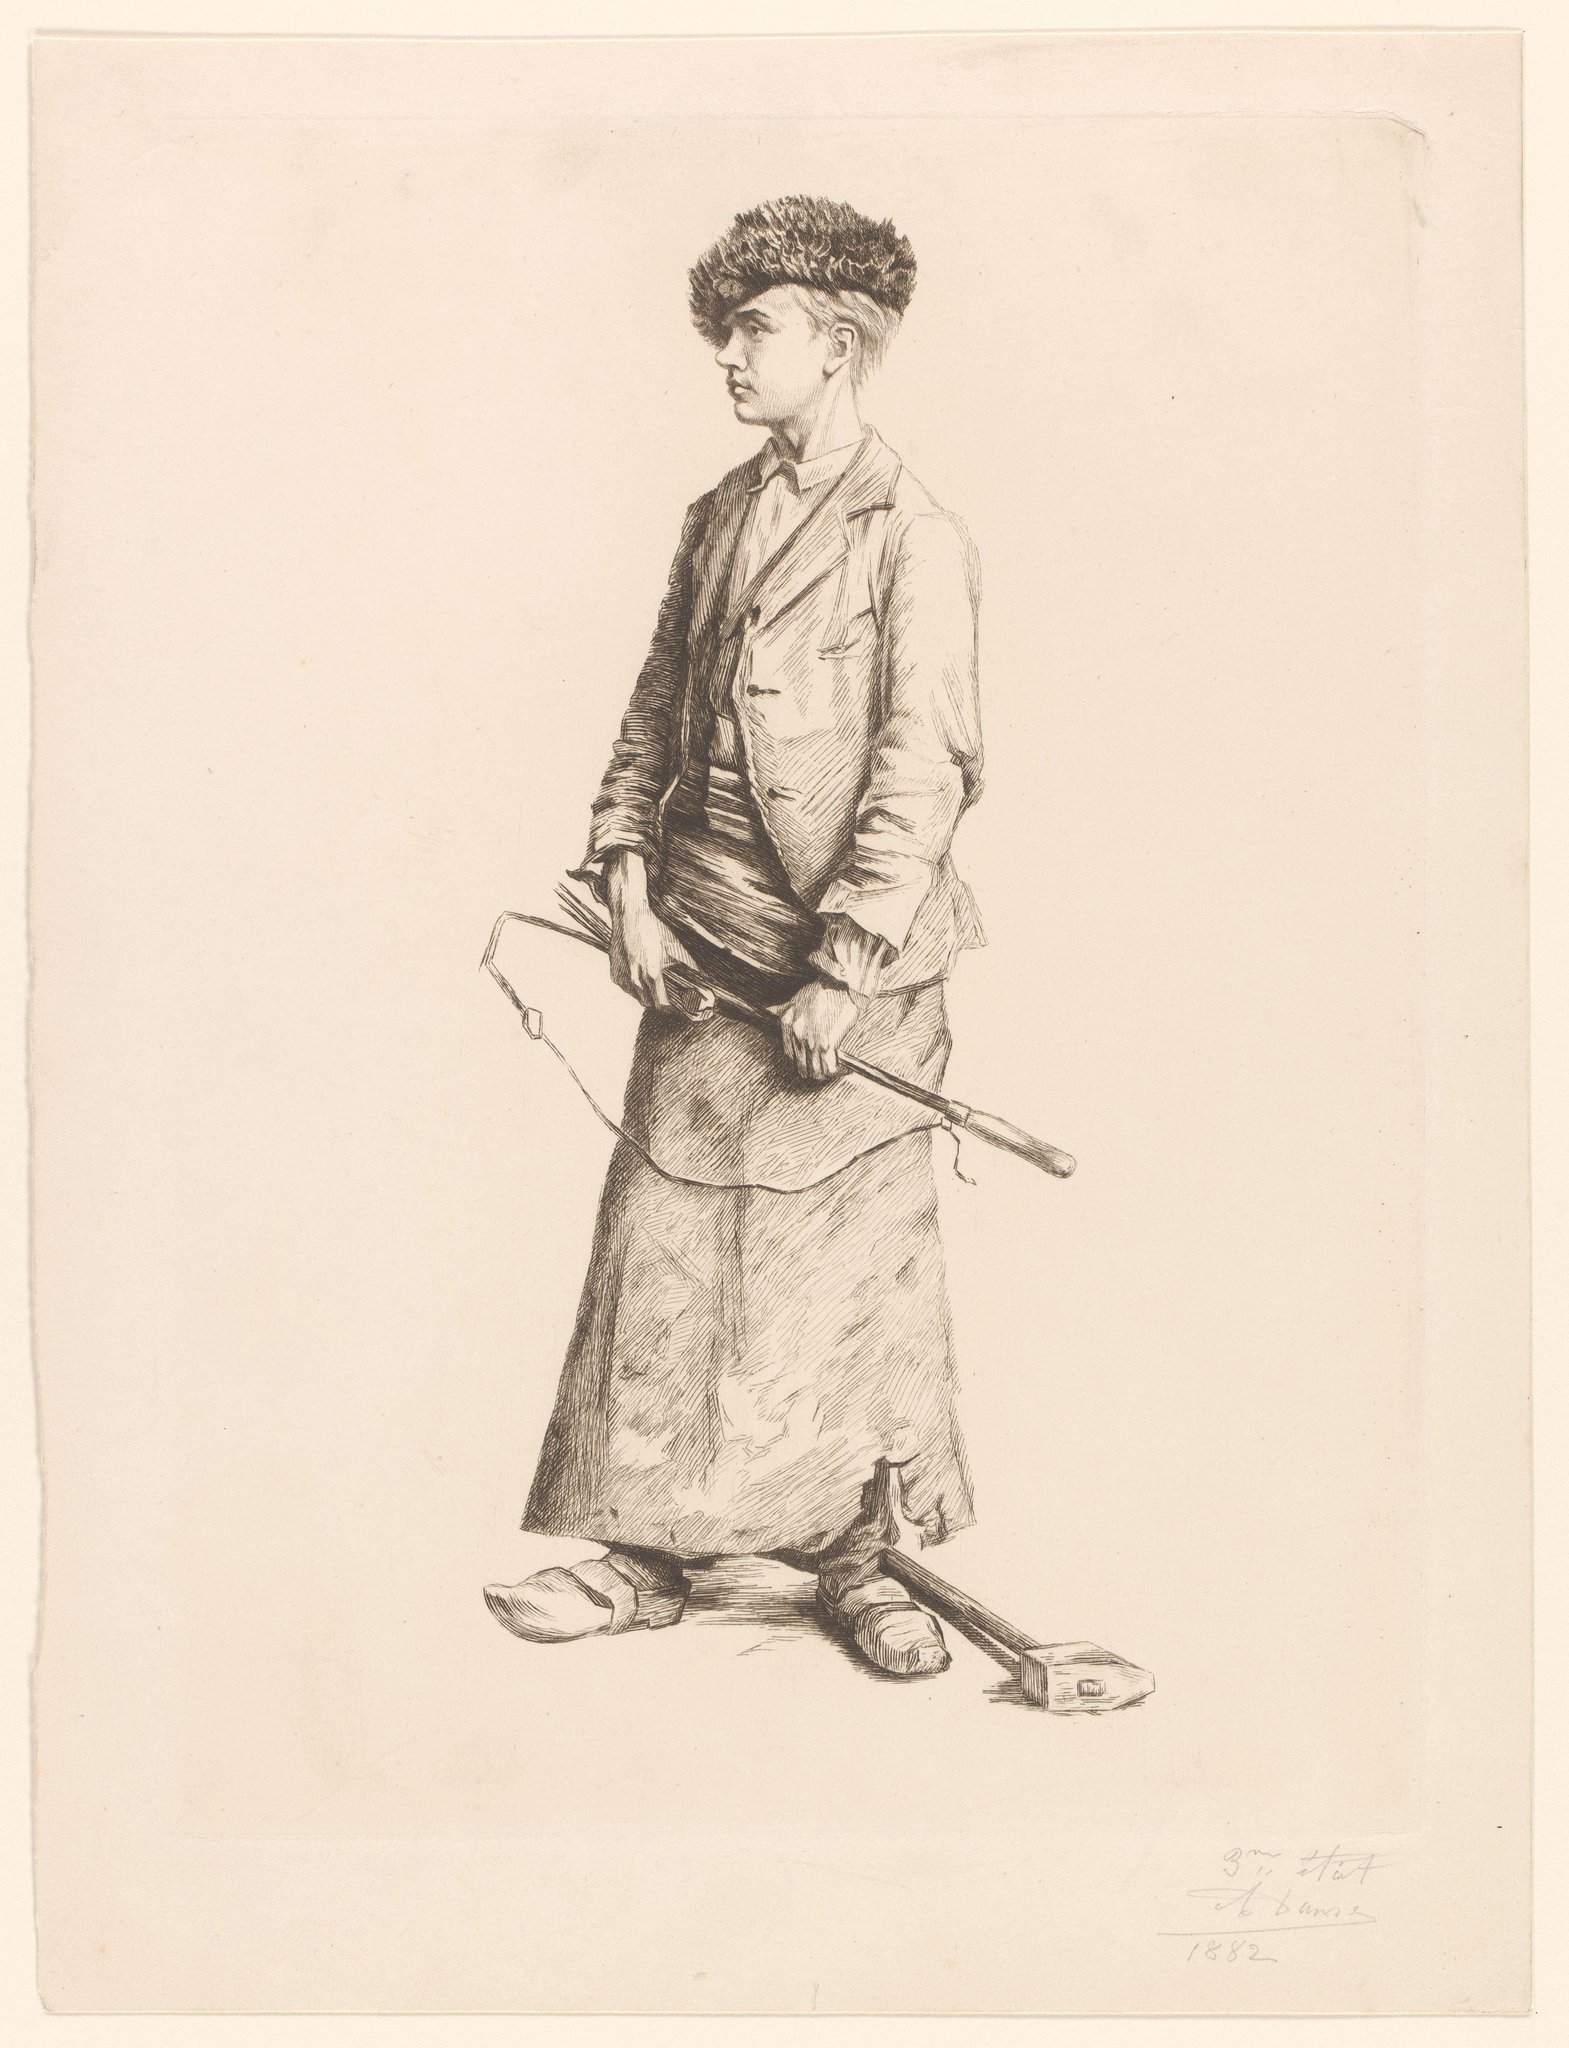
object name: print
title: Smidsjongen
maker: auguste danse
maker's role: print maker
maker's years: 1829-1929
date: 1882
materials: paper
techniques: drypoint, etching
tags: smith, blacksmith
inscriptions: annotation: ‘3me état’, collector's mark: Lugt 2228